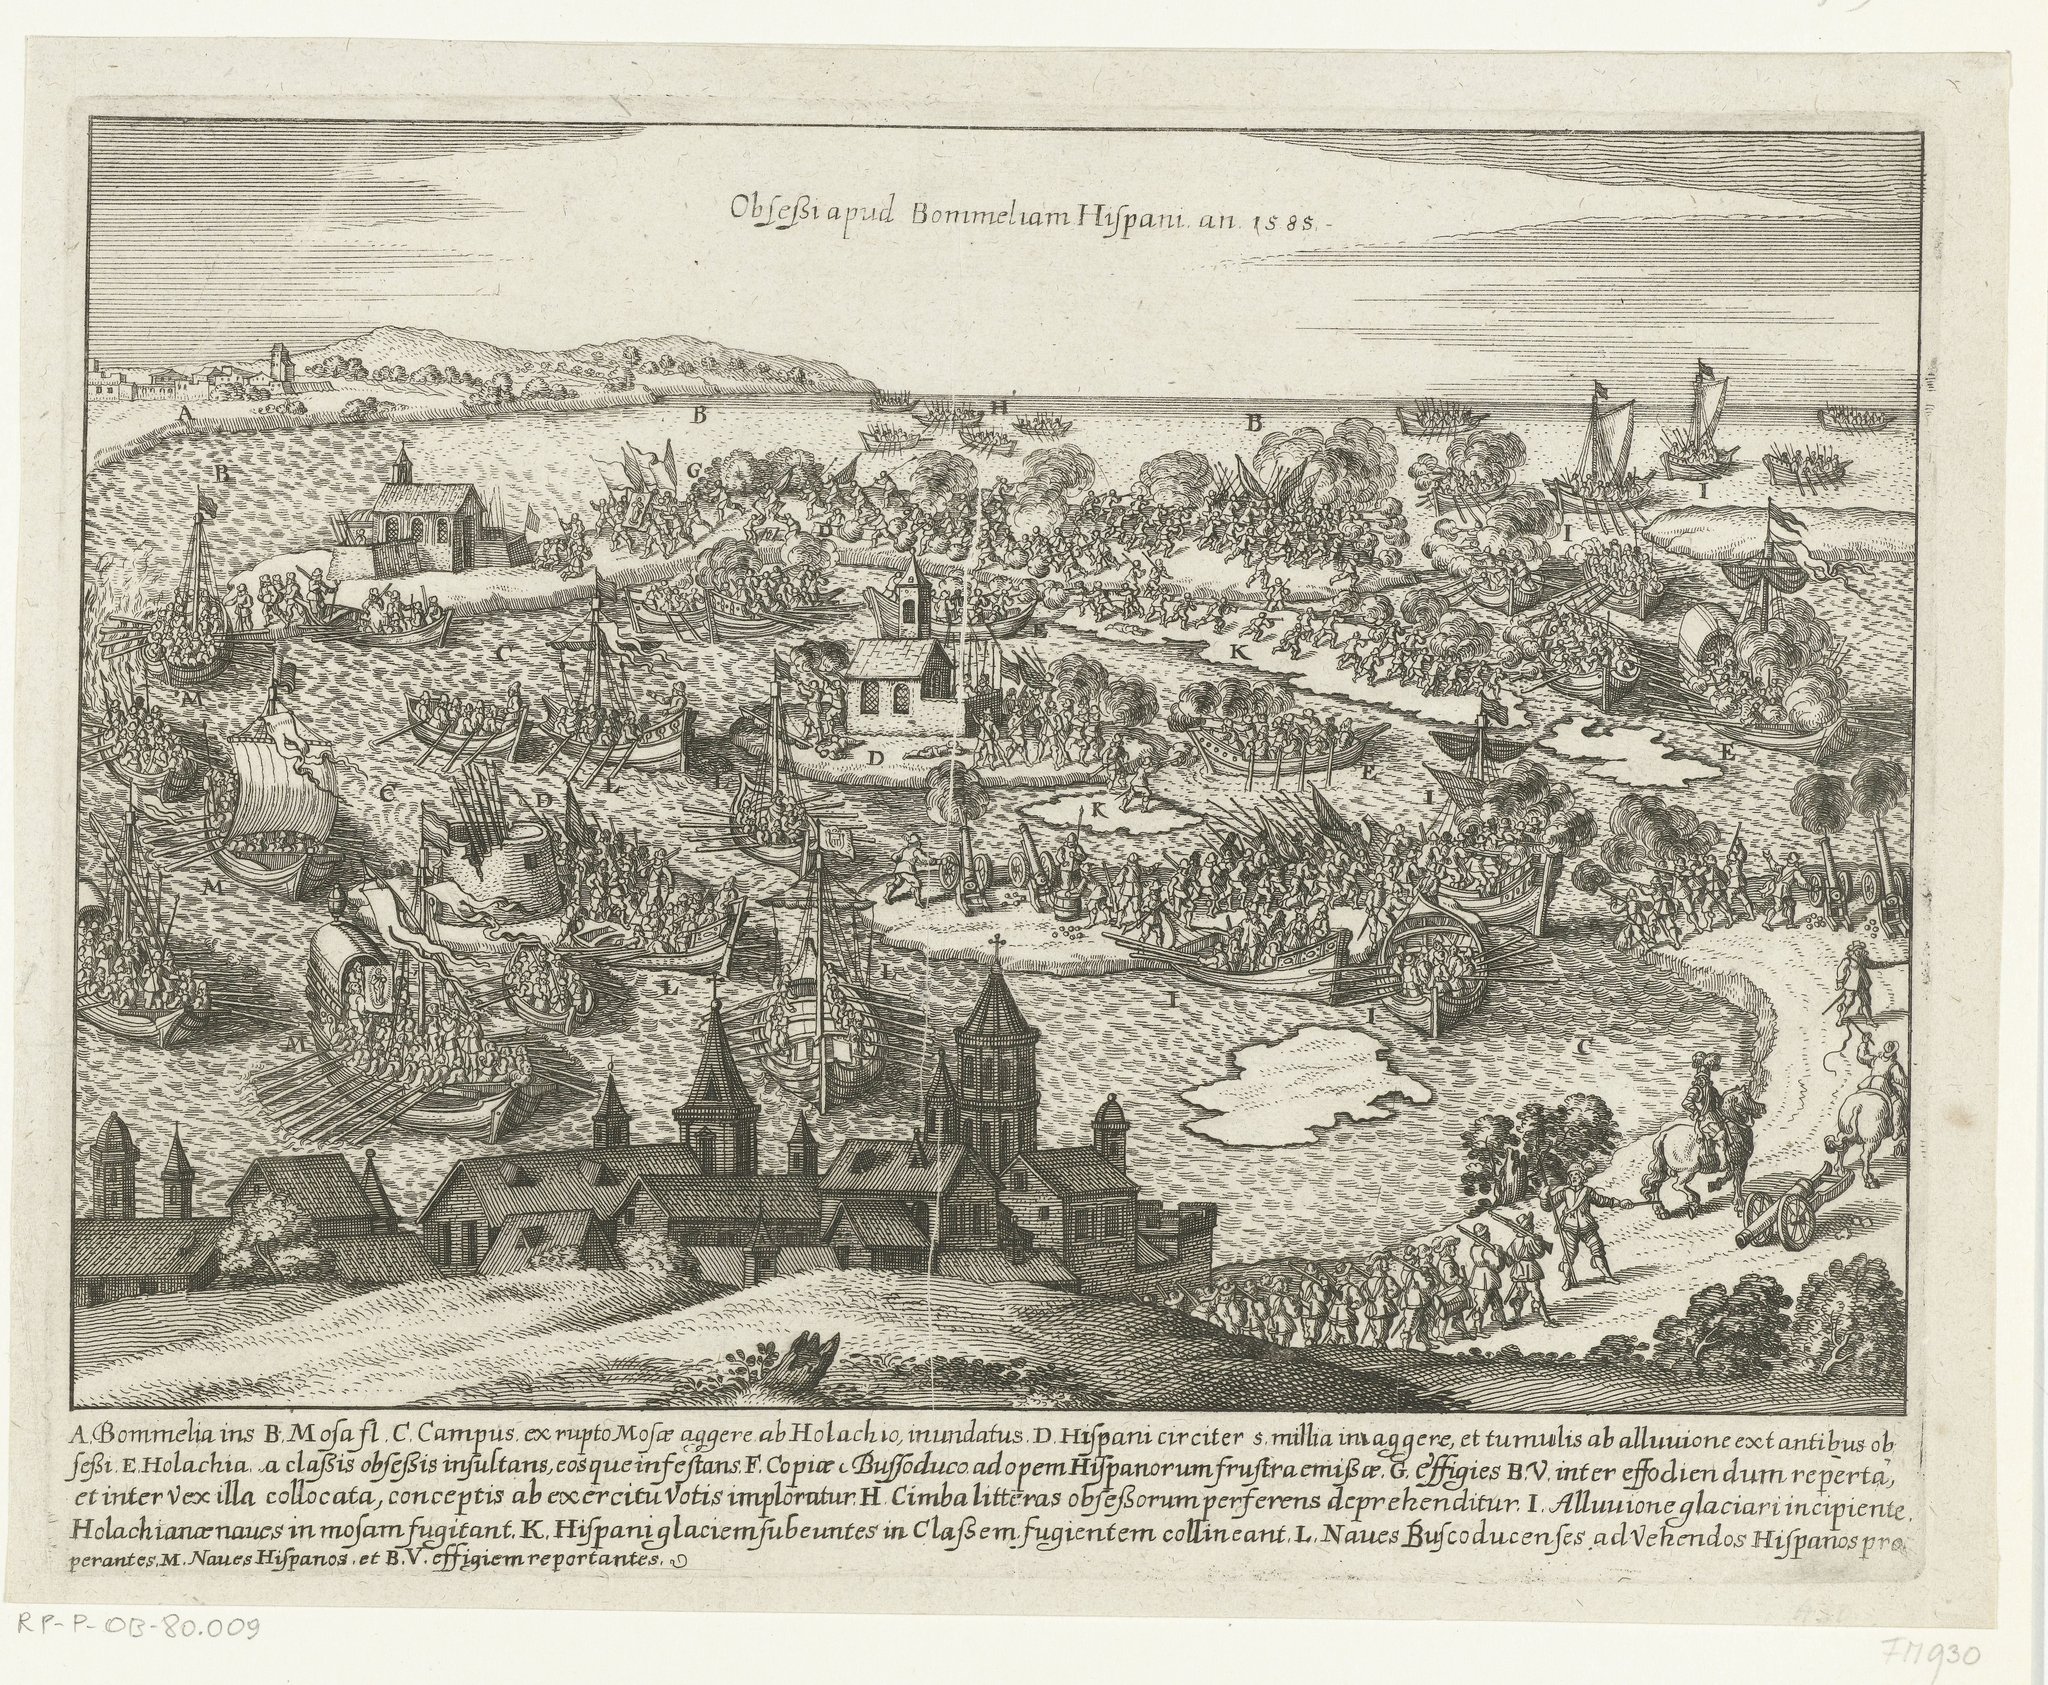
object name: print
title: Obsessi apud Bommeliam Hispani an 1585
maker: Anonymous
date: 1649-1651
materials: paper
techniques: etching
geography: rome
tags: battle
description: De Spanjaarden onder de graaf van Mansfeld door de graaf van Hohenlohe uit de Bommelerwaard verdreven door het doorsteken van de dijken, 22 december 1585. De door het water ingesloten Spaanse soldaten worden uiteindelijk gered, deze episode staat ook bekend als het wonder van Empel. In het onderschrift de legenda A-M in het Latijn.